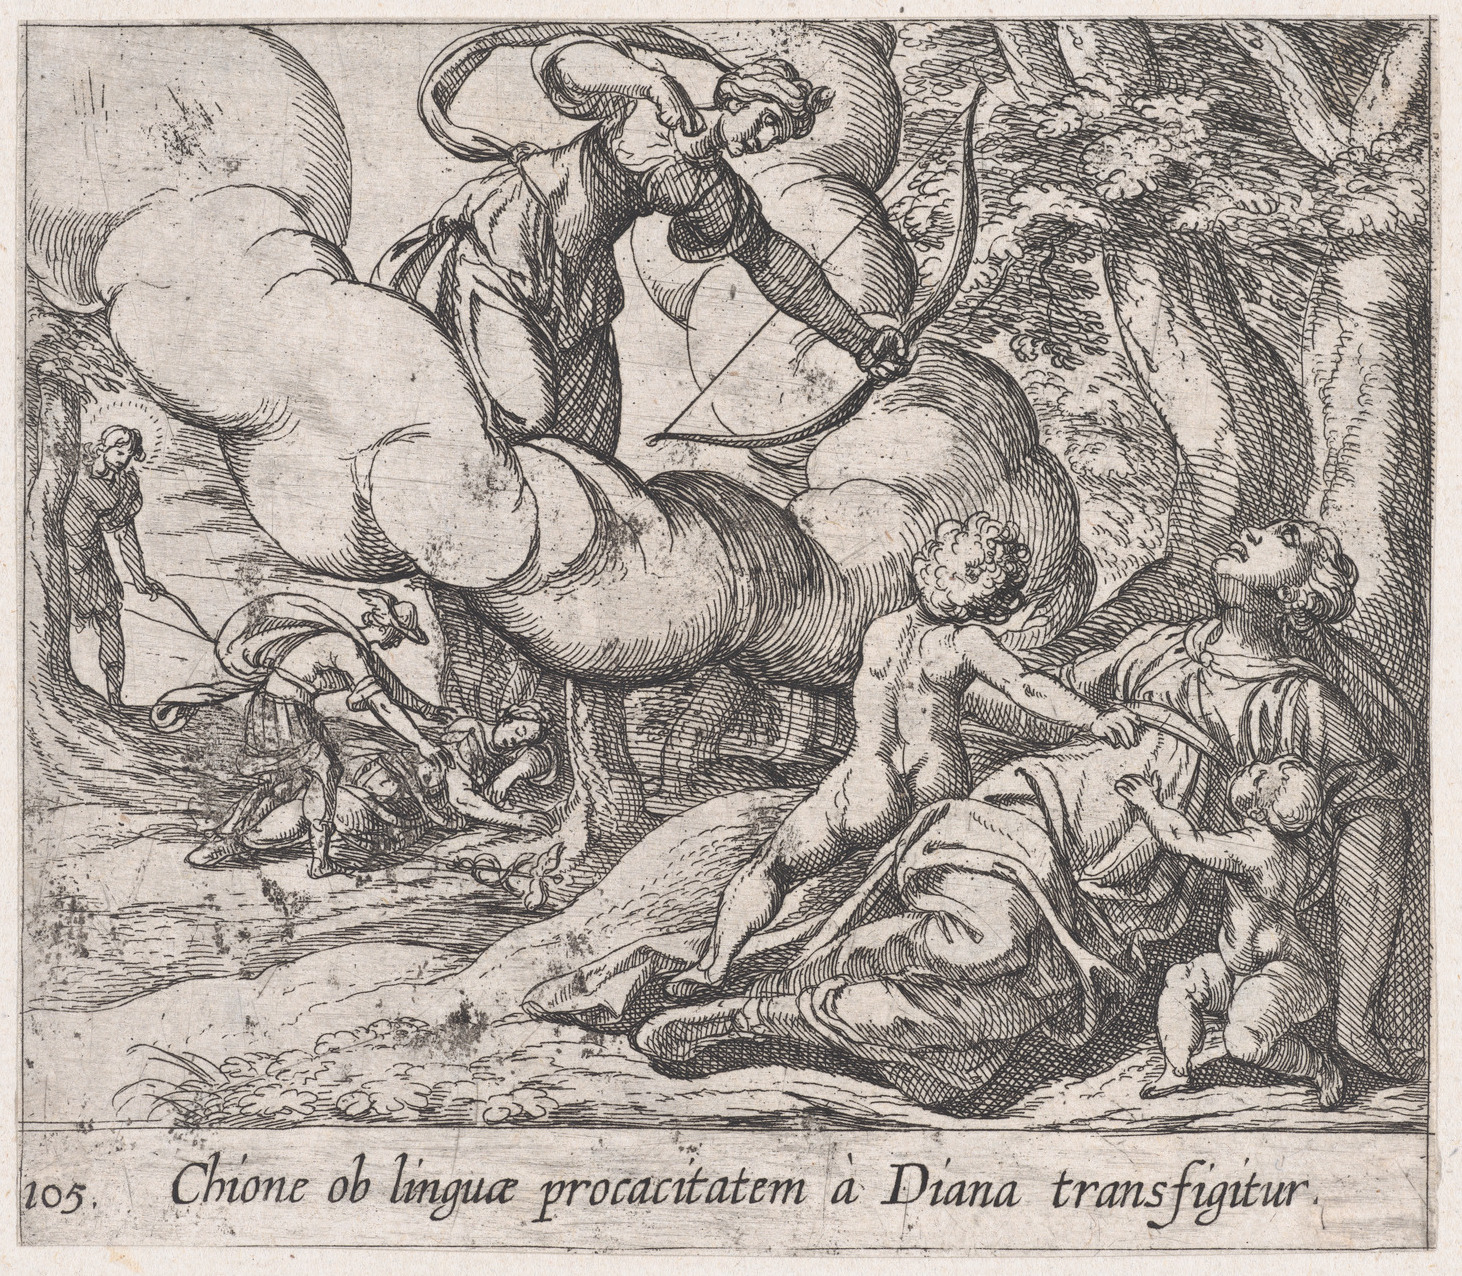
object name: print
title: Plate 105: Diane Killing Chione (Chione ob linguae procacitatem a Diana transfigitur), from Ovid's 'Metamorphoses'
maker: antonio tempesta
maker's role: artist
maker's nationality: italian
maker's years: 1555-1630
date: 1606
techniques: etching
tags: bow and arrow,children,men,women,diana